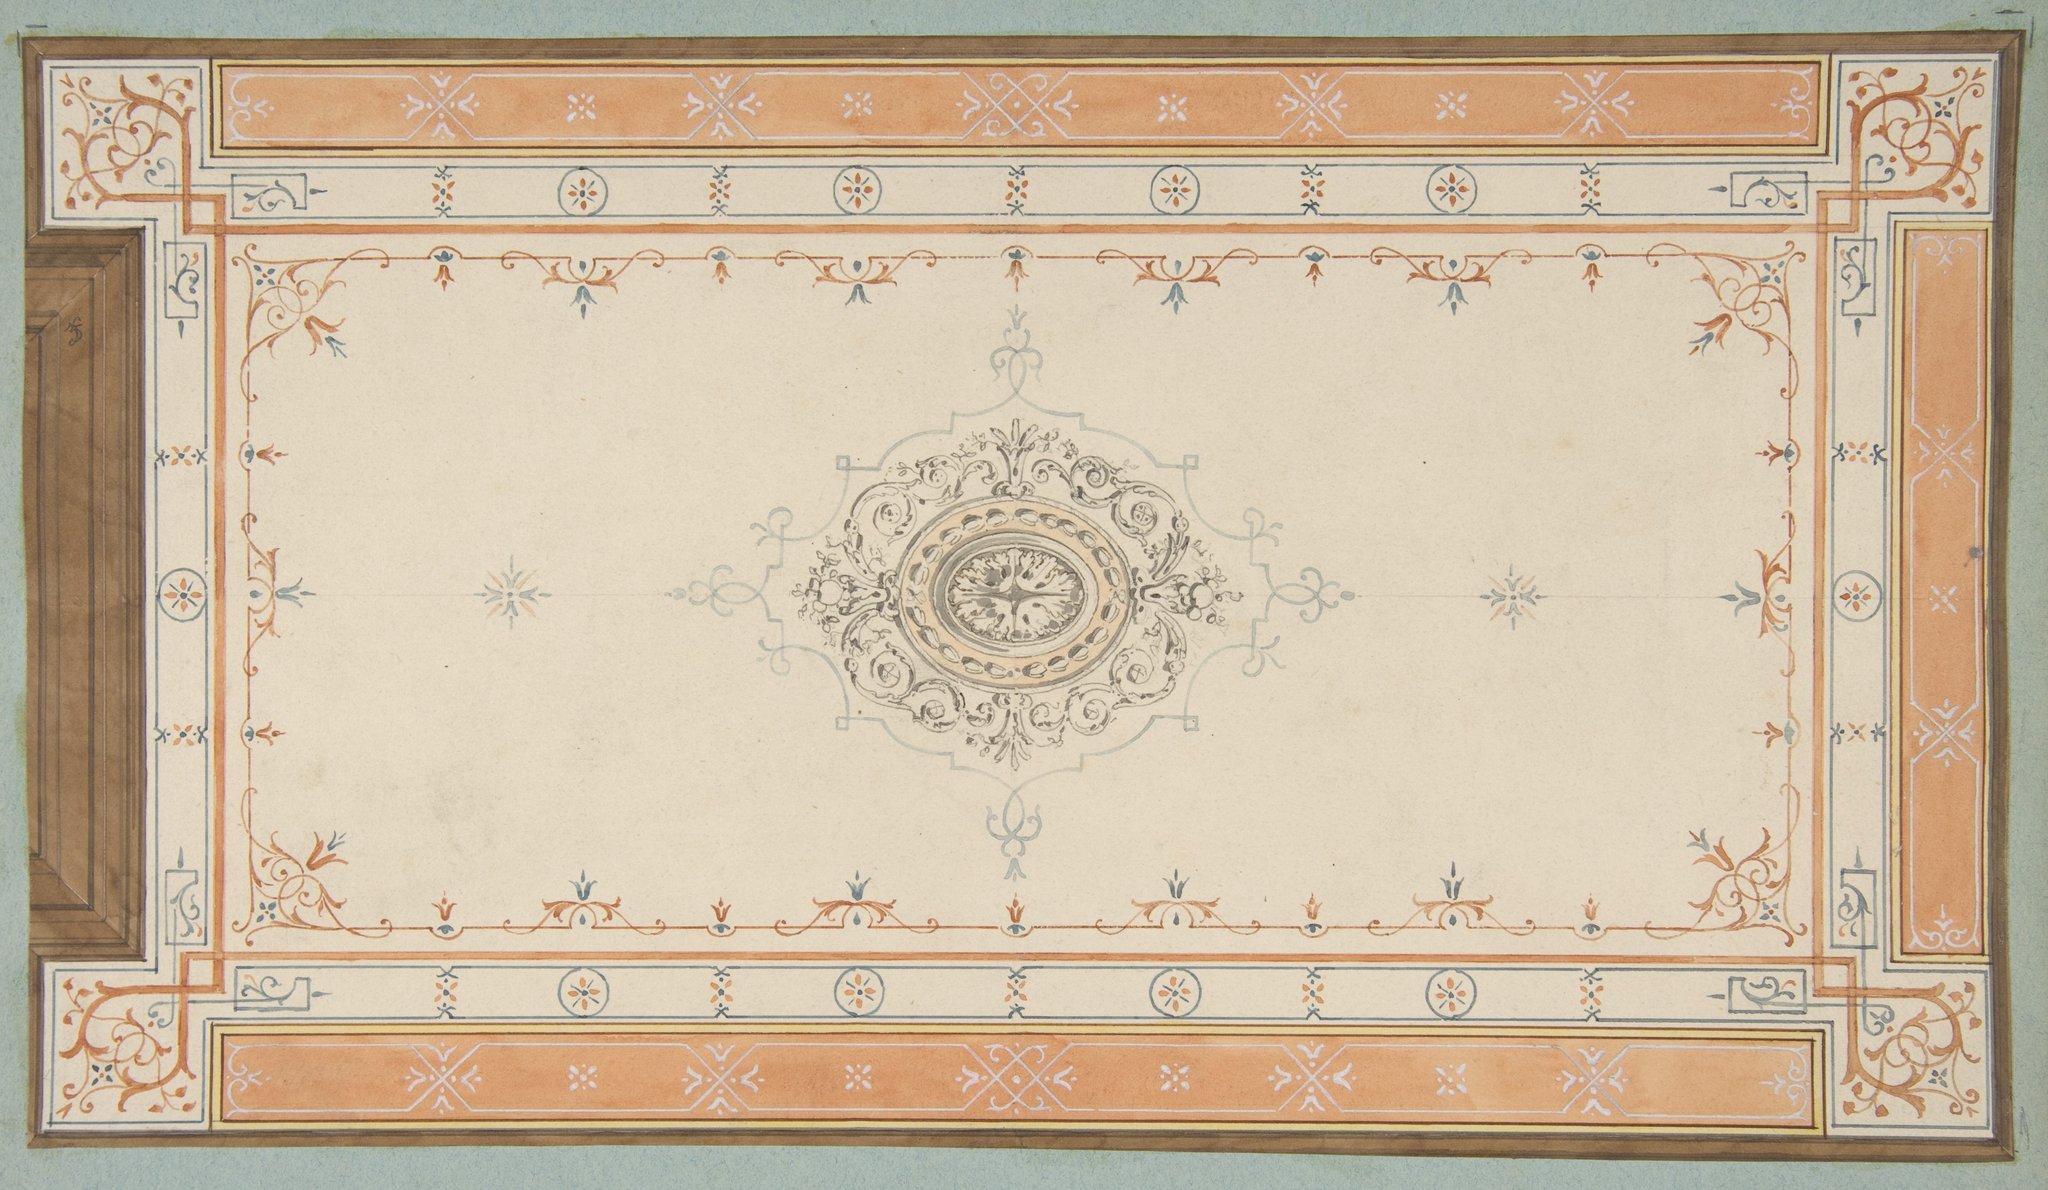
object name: drawing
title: Design for the decoration of a ceiling with filagree borders and a central medallion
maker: jules-edmond-charles lachaise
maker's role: artist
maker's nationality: french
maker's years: 1897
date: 1830-1897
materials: graphite, paper, watercolor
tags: ceilings